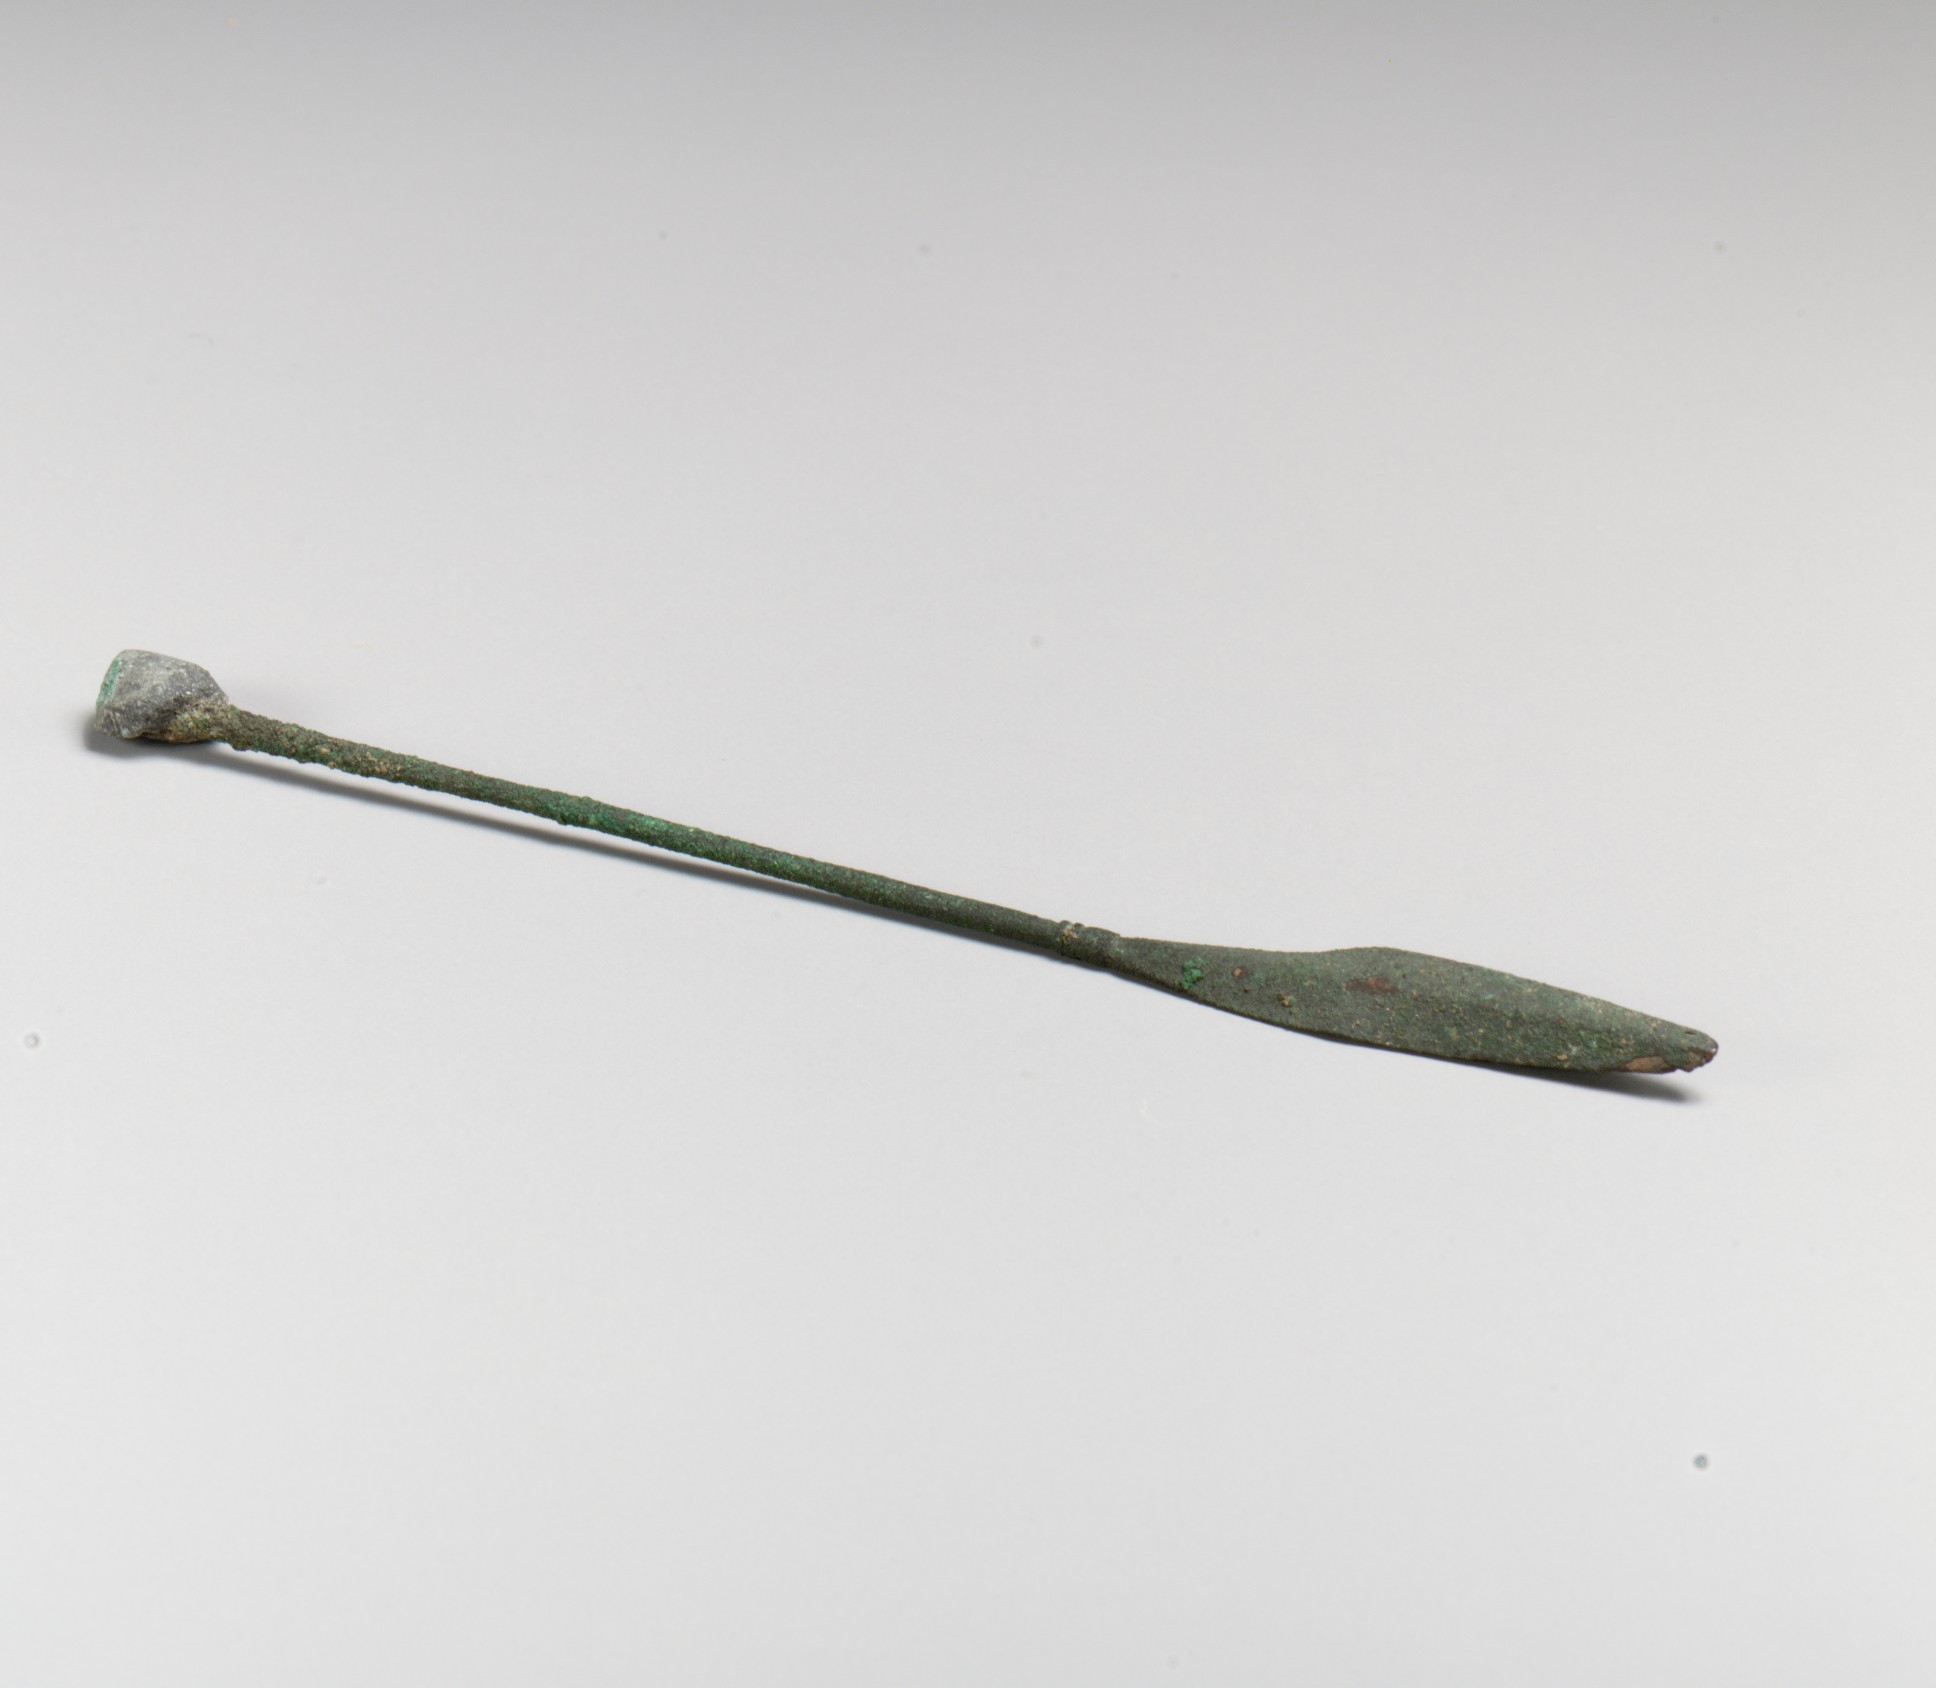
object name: spatula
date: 7000 BCE-330 CE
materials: bronze